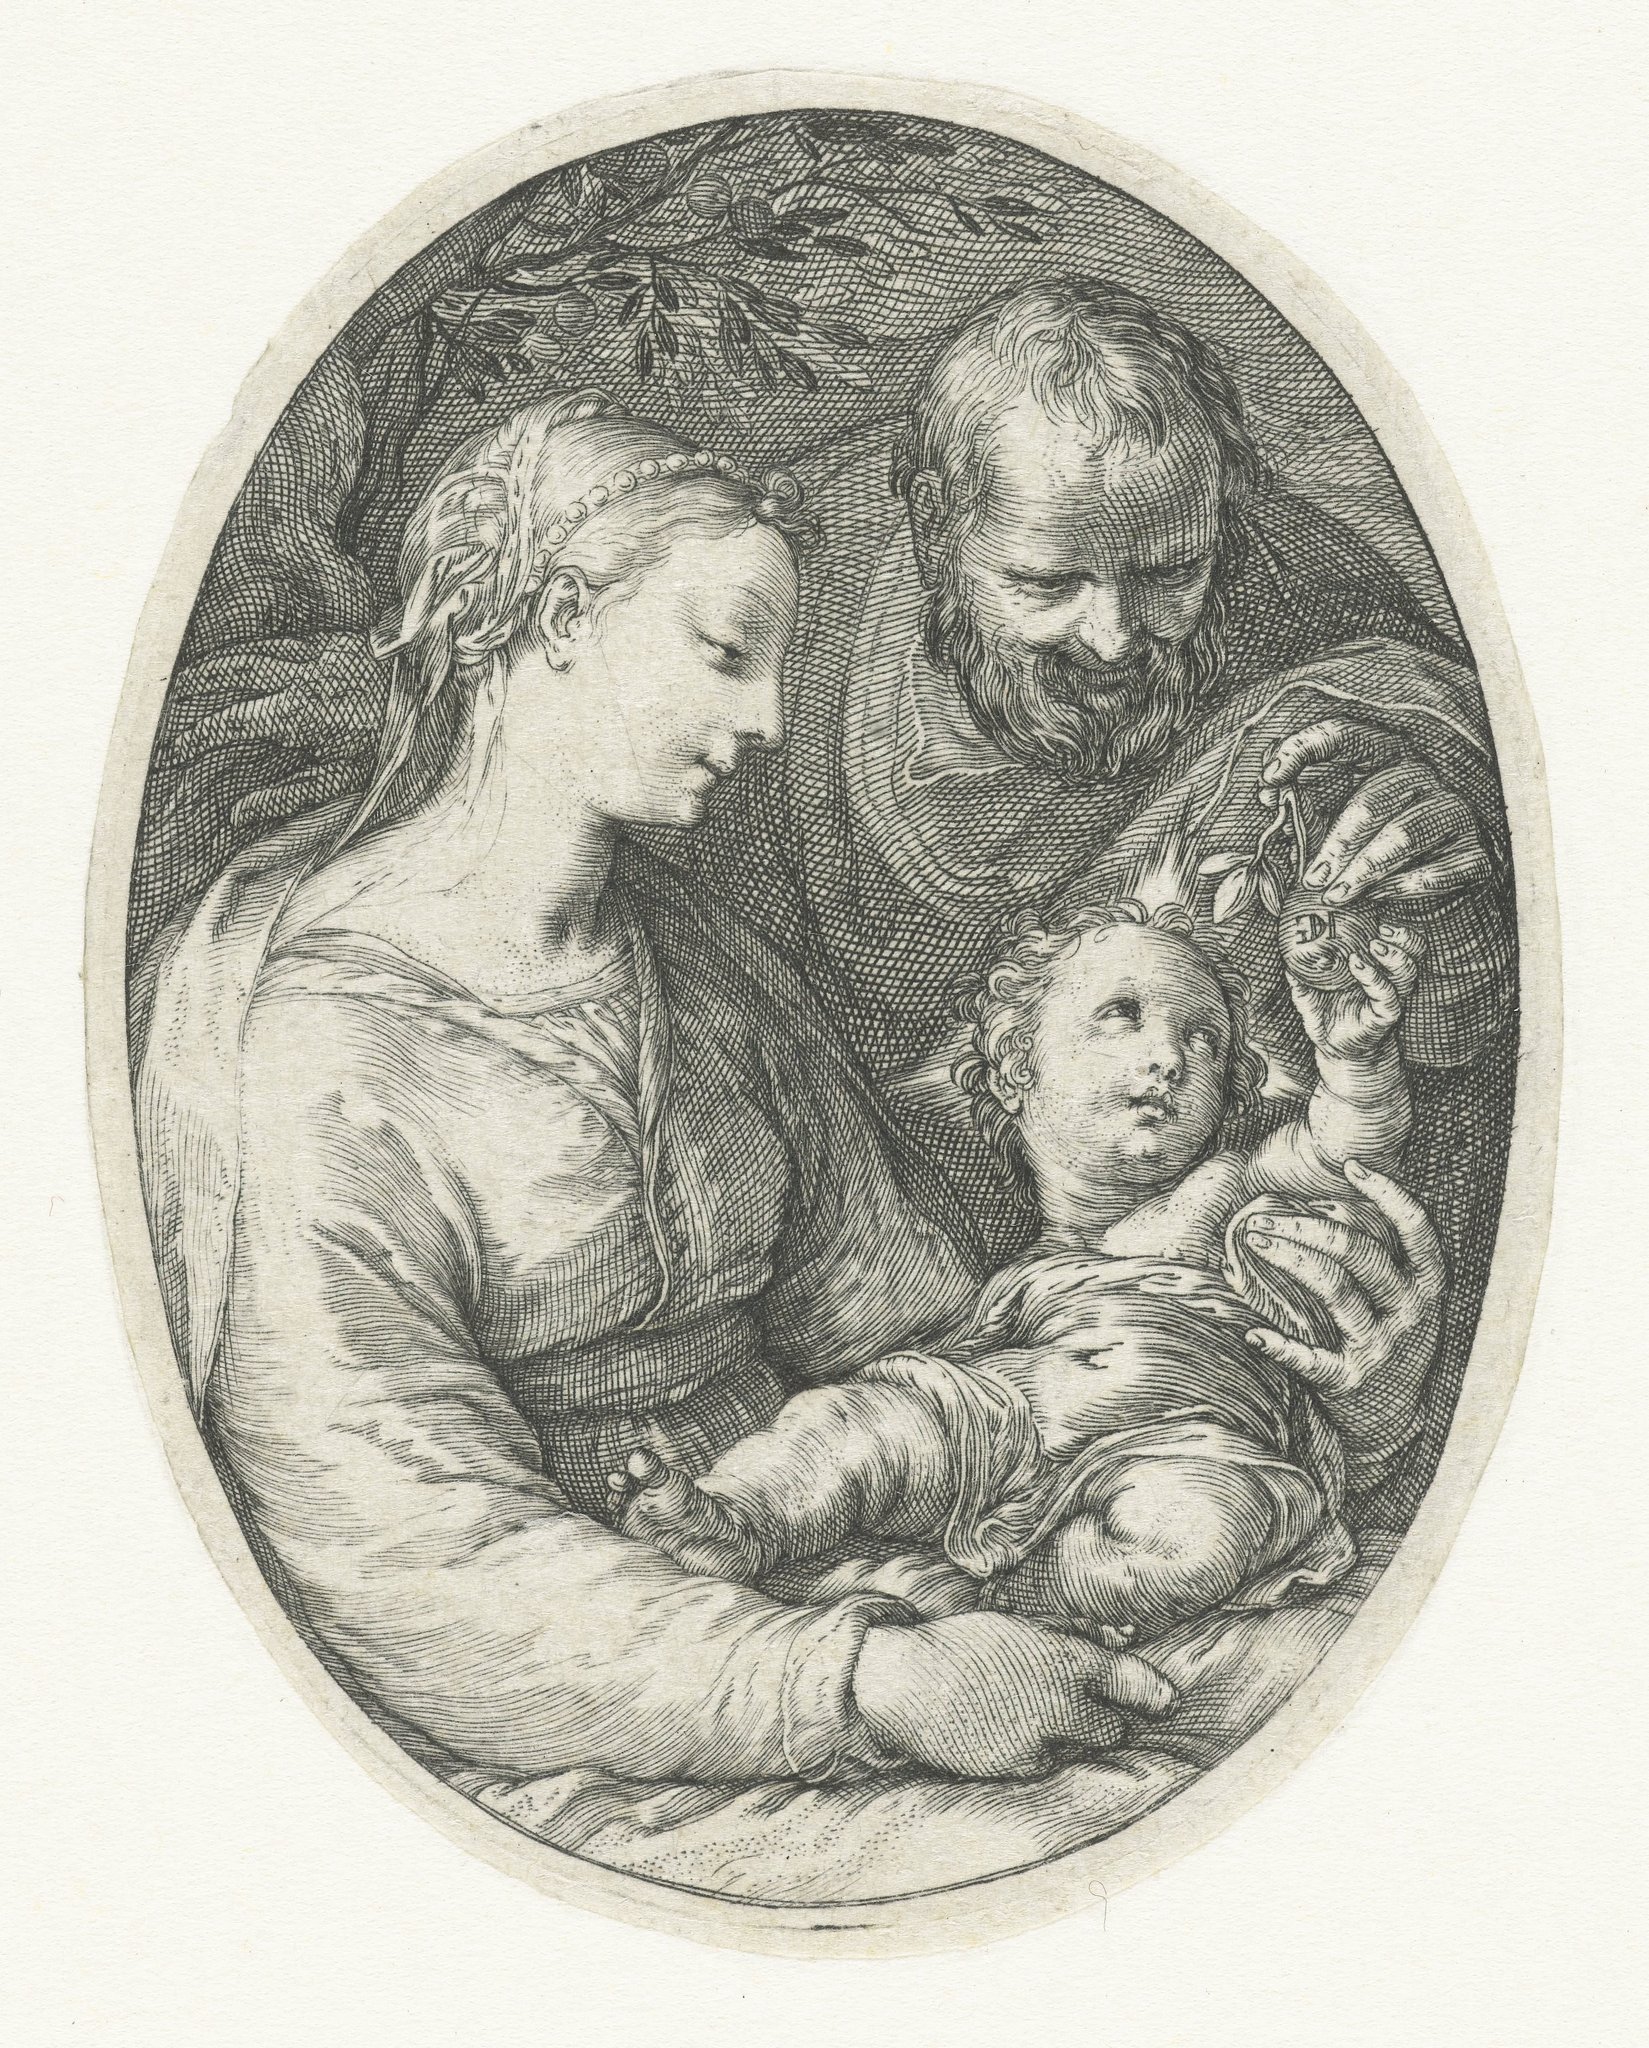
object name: print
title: De Heilige Familie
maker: hendrick goltzius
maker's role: draughtsman, painter, print maker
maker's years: 1558-1617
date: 1593-1597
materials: paper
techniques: engraving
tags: holy family, and derived representations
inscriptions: mark: ‘A. Alferoff’ Lugt 1727, mark: Lugt 2227, monogram: ‘HG’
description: Heilige familie. Voorstelling geplaatst in een ovaal. Christus kind op schoot Maria. Christus kind neemt een appel aan van Jozef.